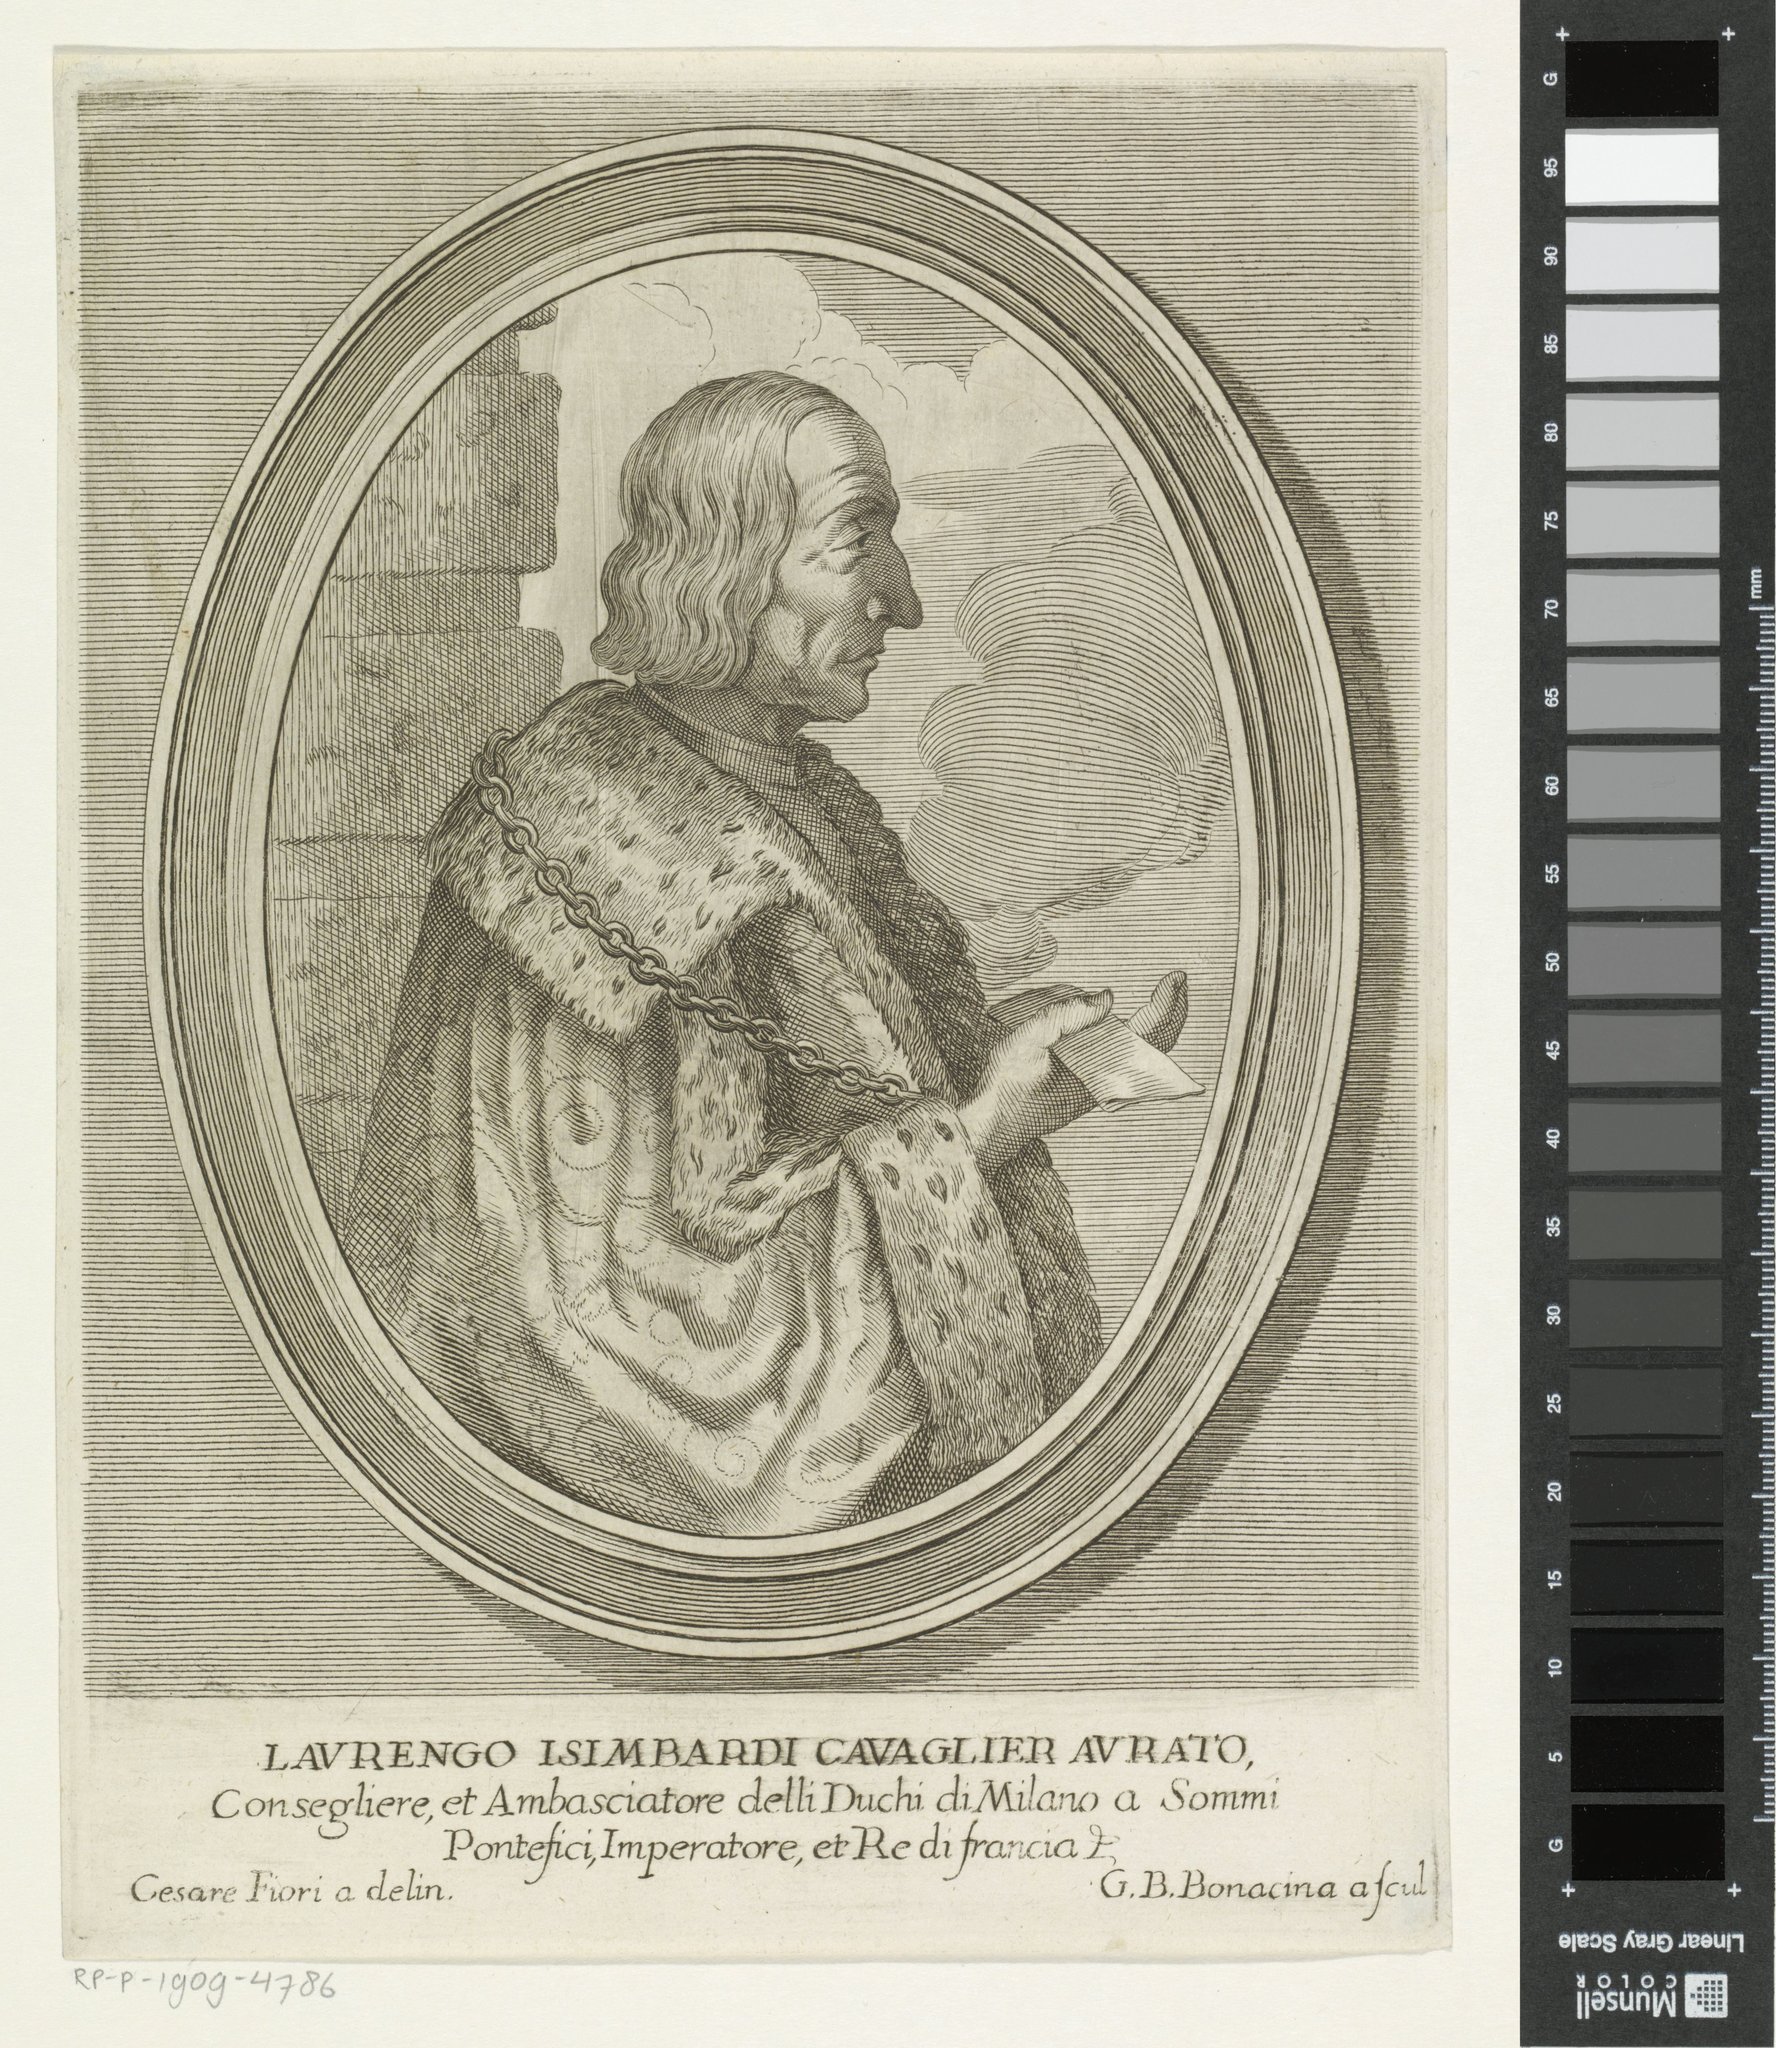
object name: print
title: Portret van Laurengo Isimbardi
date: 1625-1669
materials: paper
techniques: engraving, etching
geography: italy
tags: historical persons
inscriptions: collector's mark: Lugt 2228